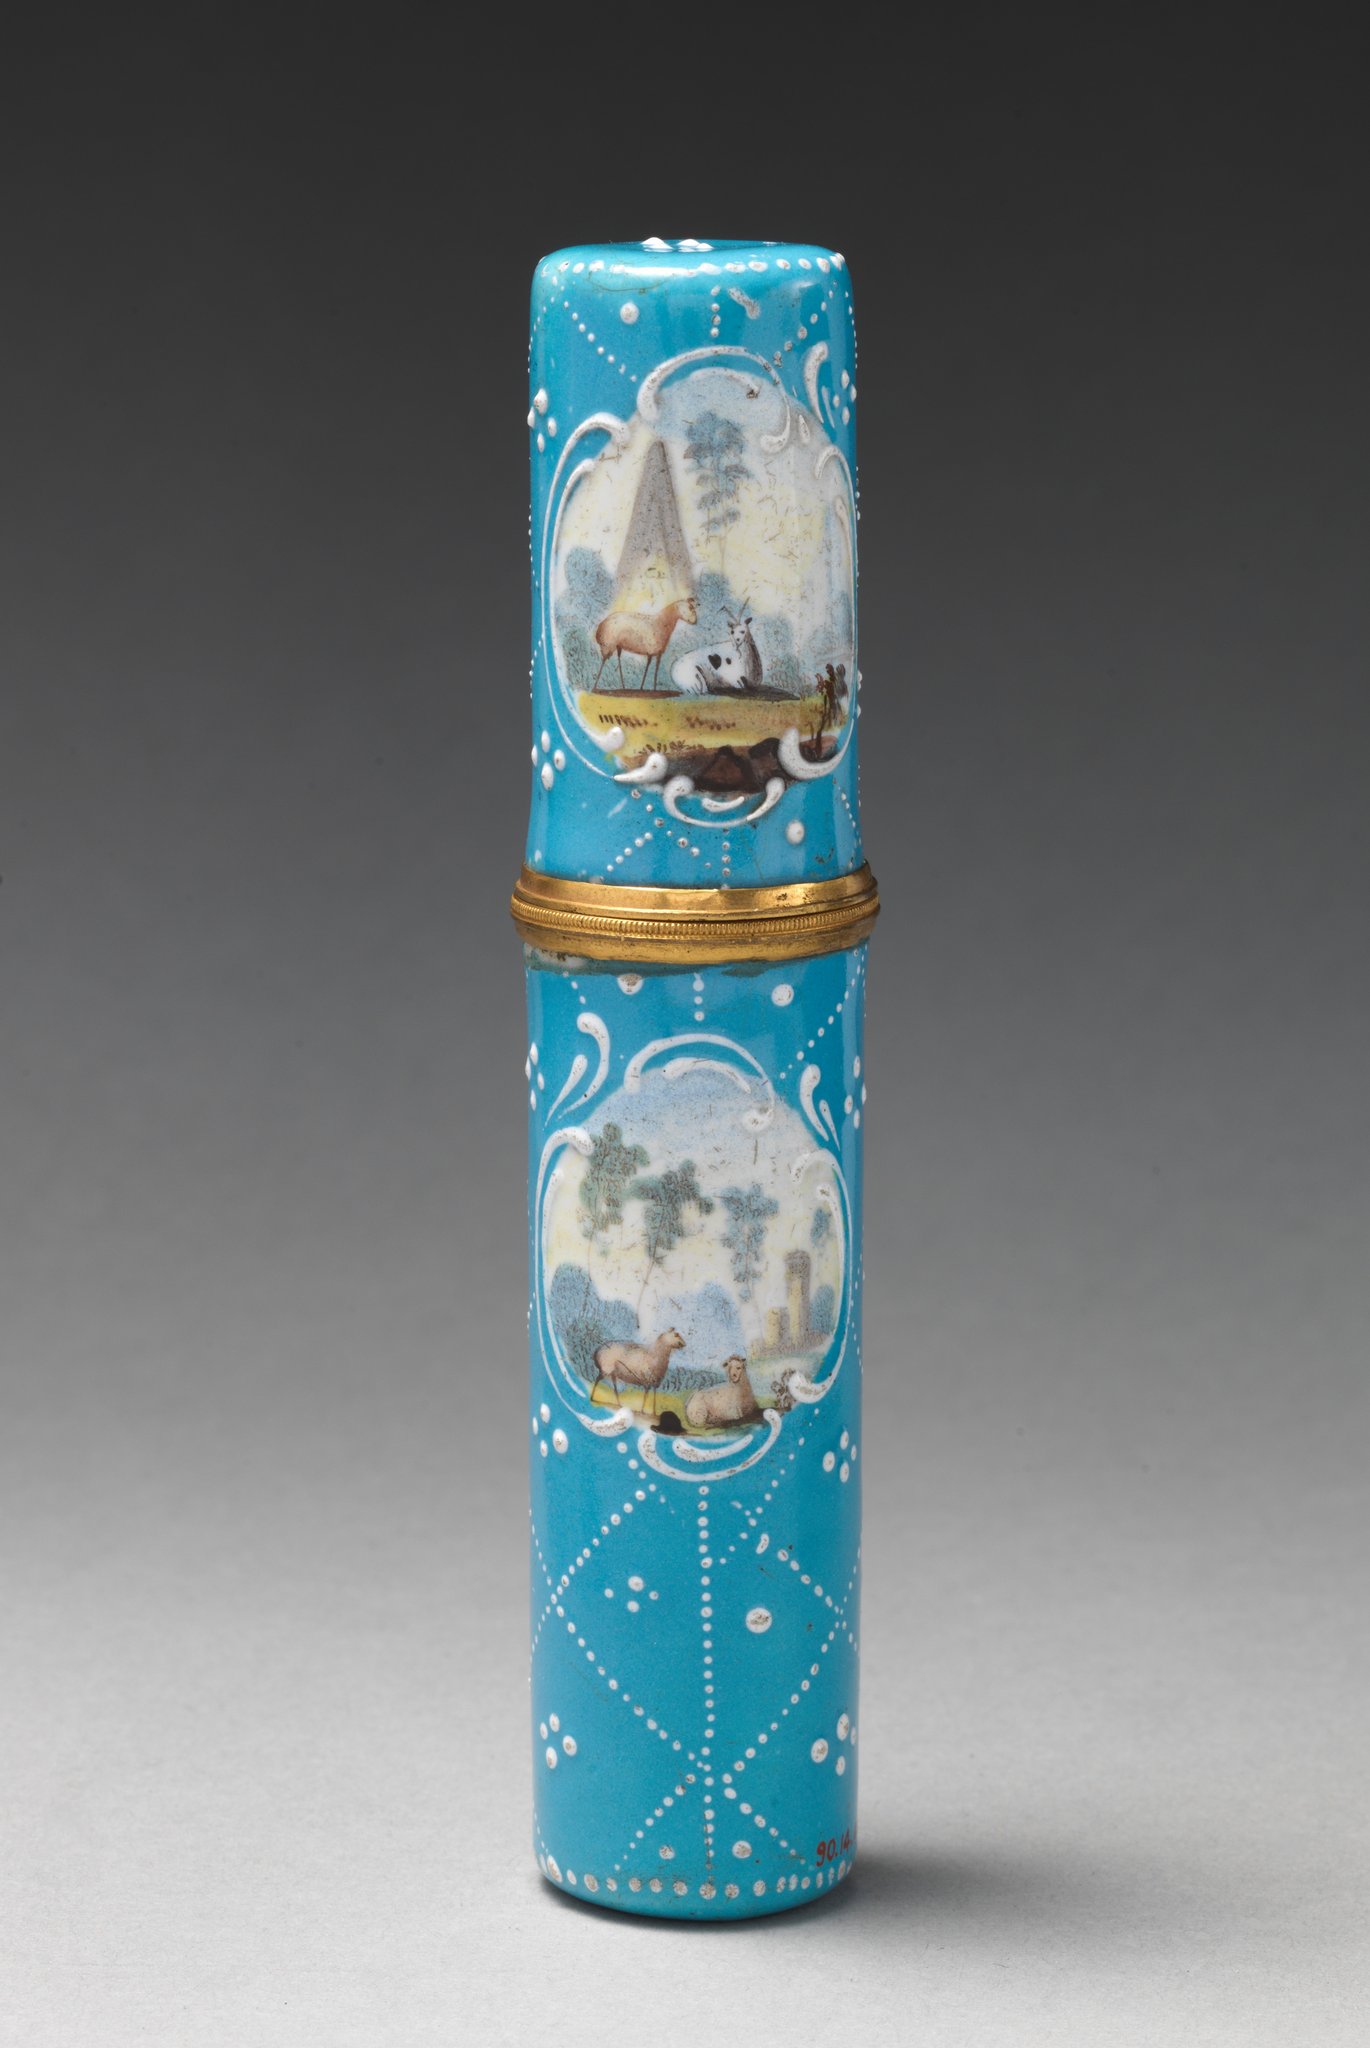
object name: étui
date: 1765-1770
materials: copper, enamel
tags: animals,trees